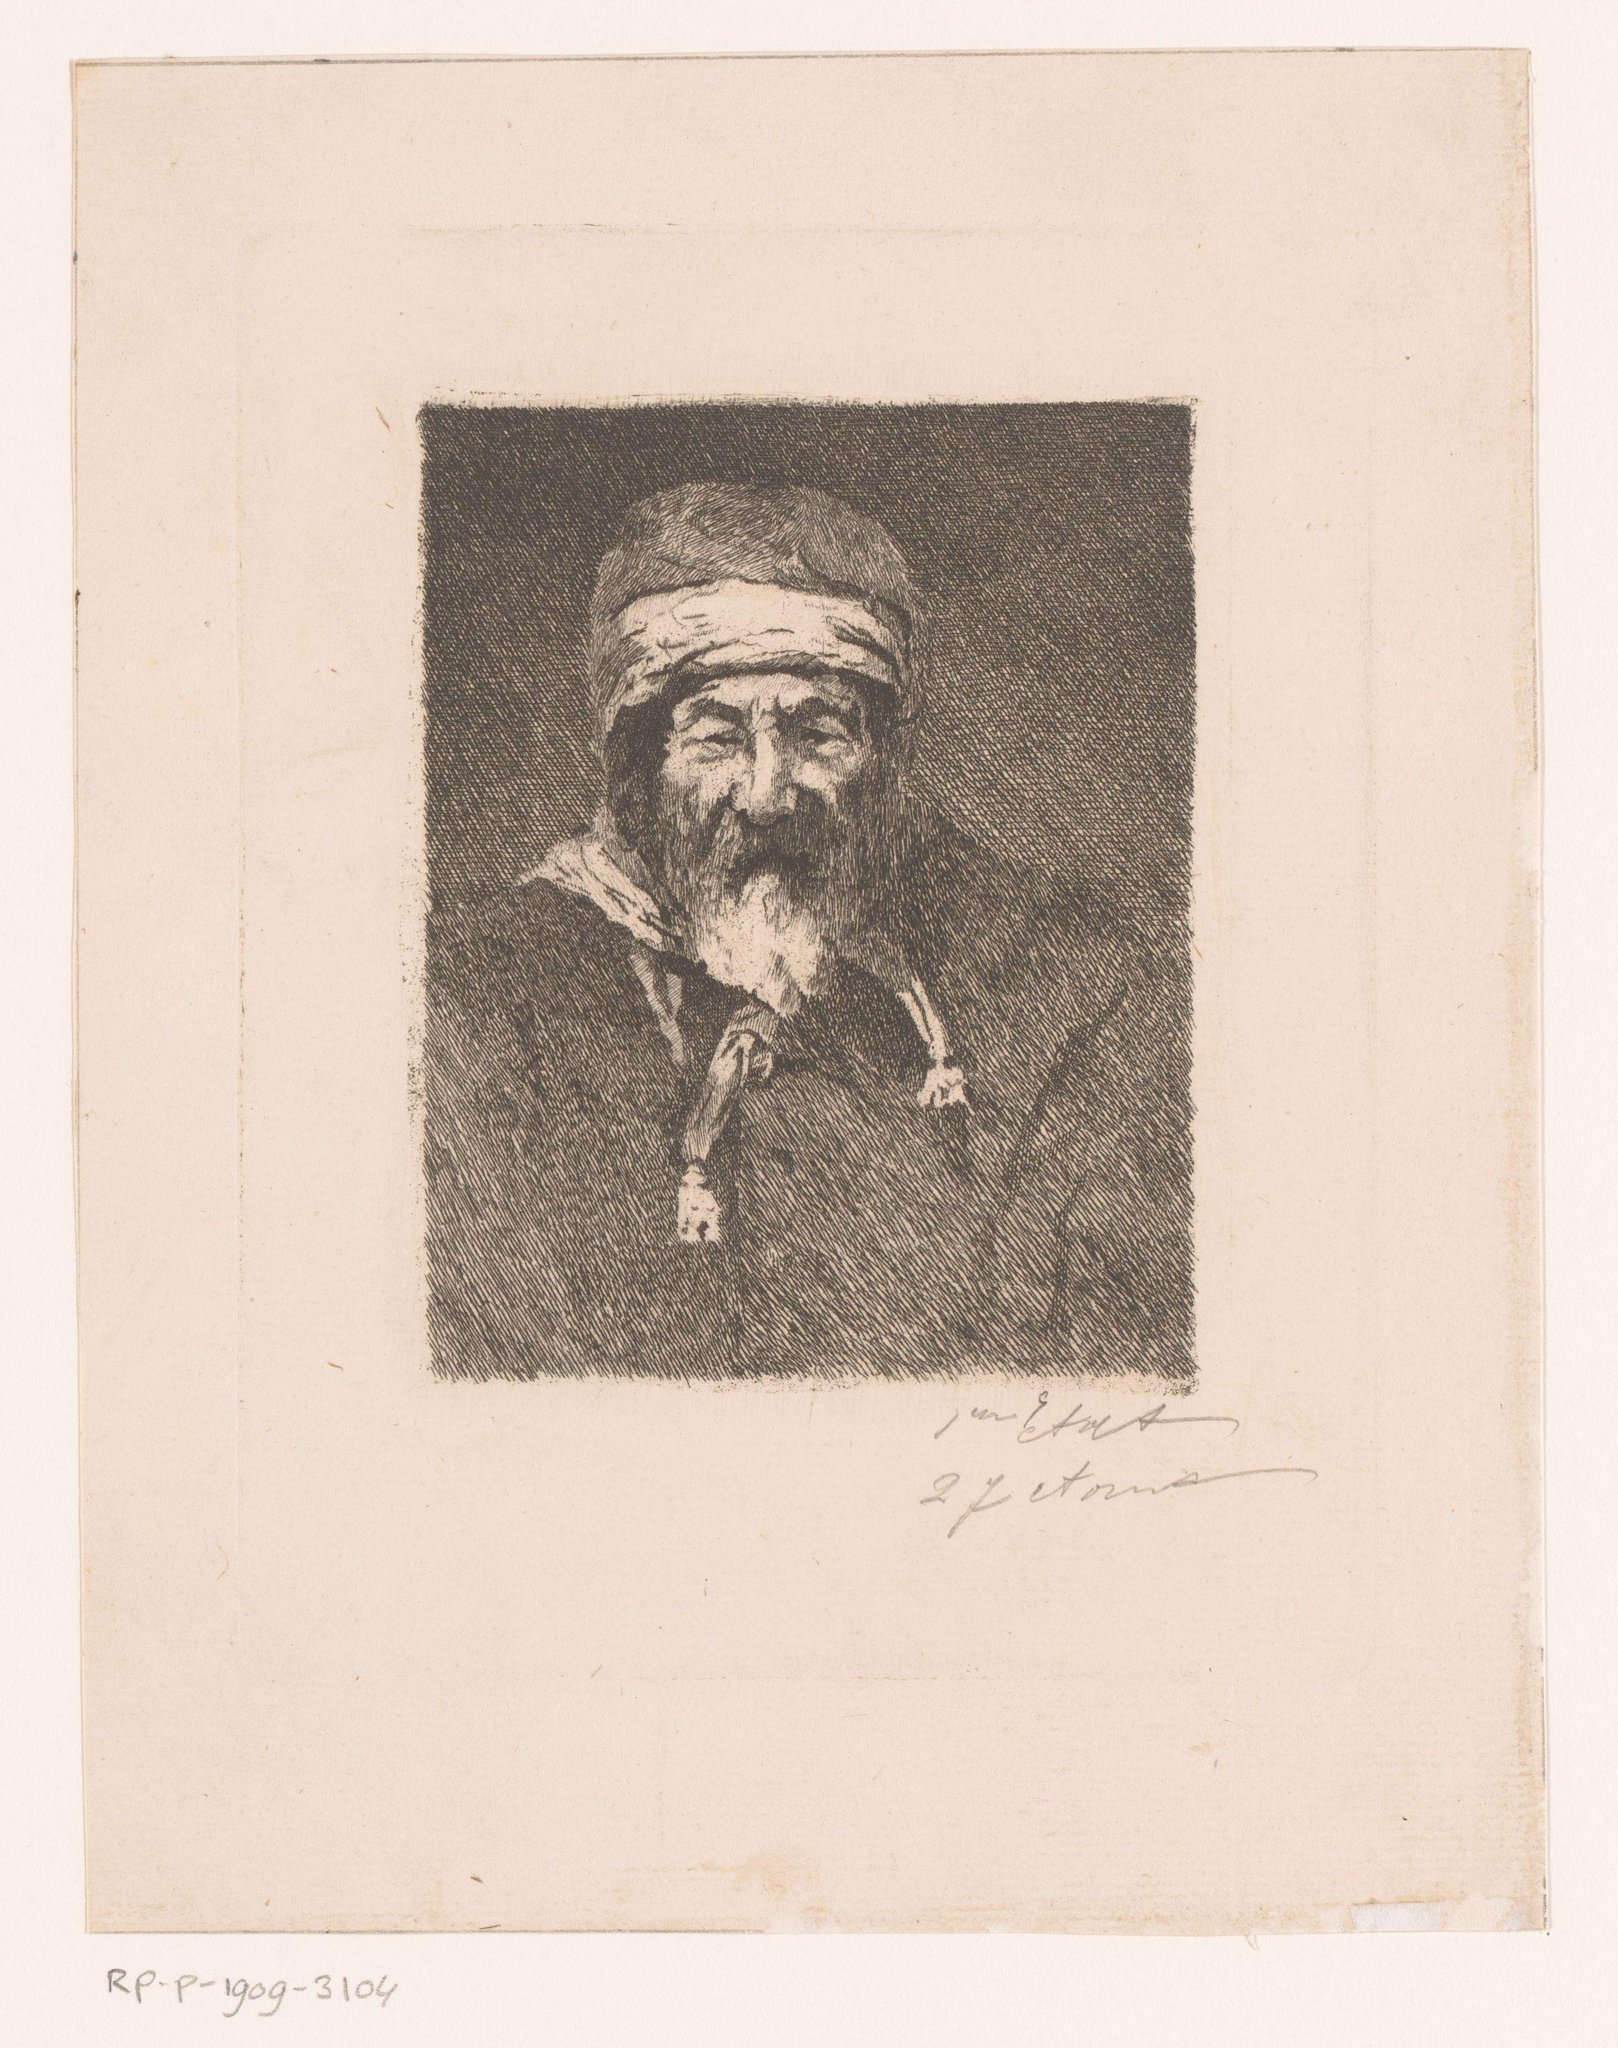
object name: print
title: Kop van een oude man met baard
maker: eugène cosyns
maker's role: print maker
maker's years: 1862-1909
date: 1872-1909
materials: paper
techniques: etching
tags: old man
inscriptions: inscription: ‘1em etat [...]’, collector's mark: Lugt 2228